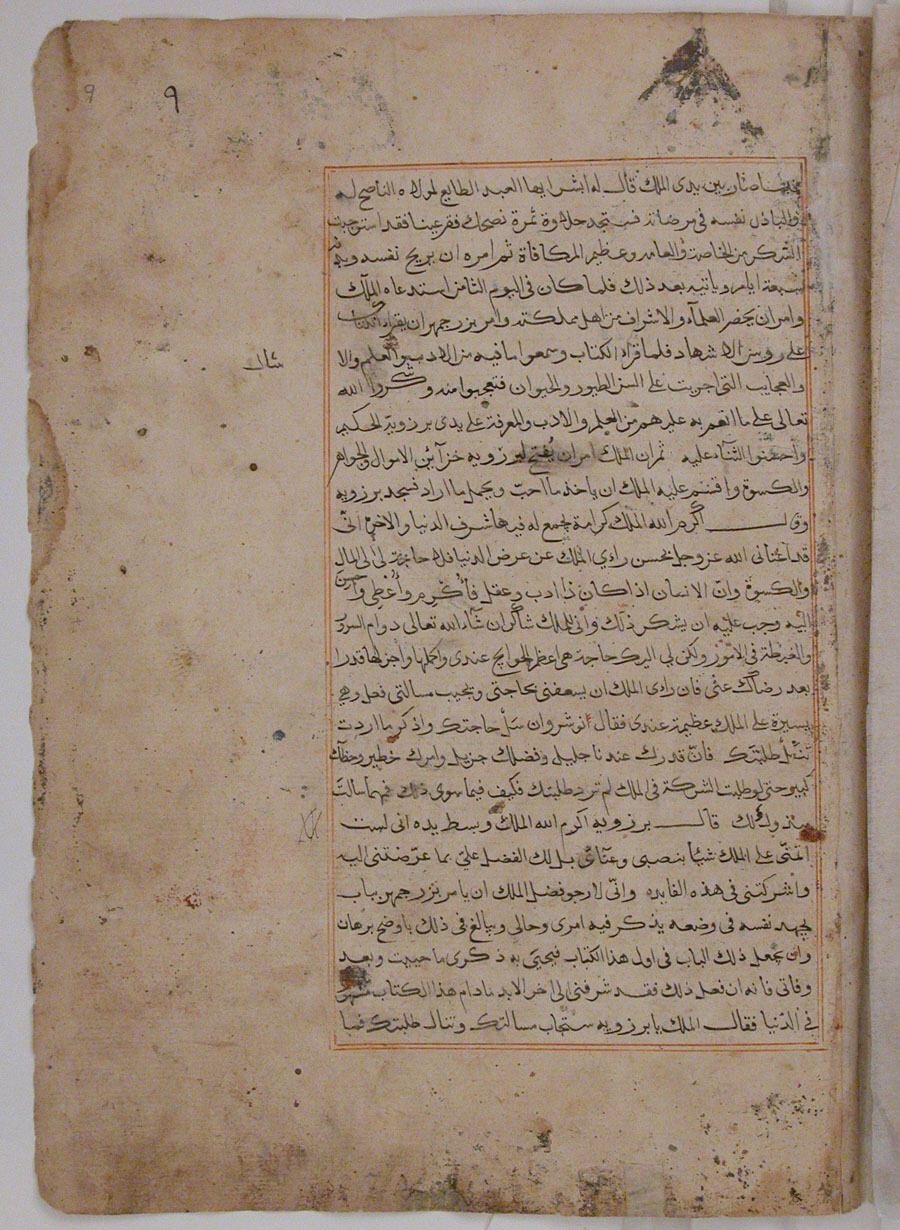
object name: folio from an illustrated manuscript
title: Page of Calligraphy from a Kalila wa Dimna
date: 1526-1550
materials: ink, paper, watercolor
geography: india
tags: arabic,calligraphy